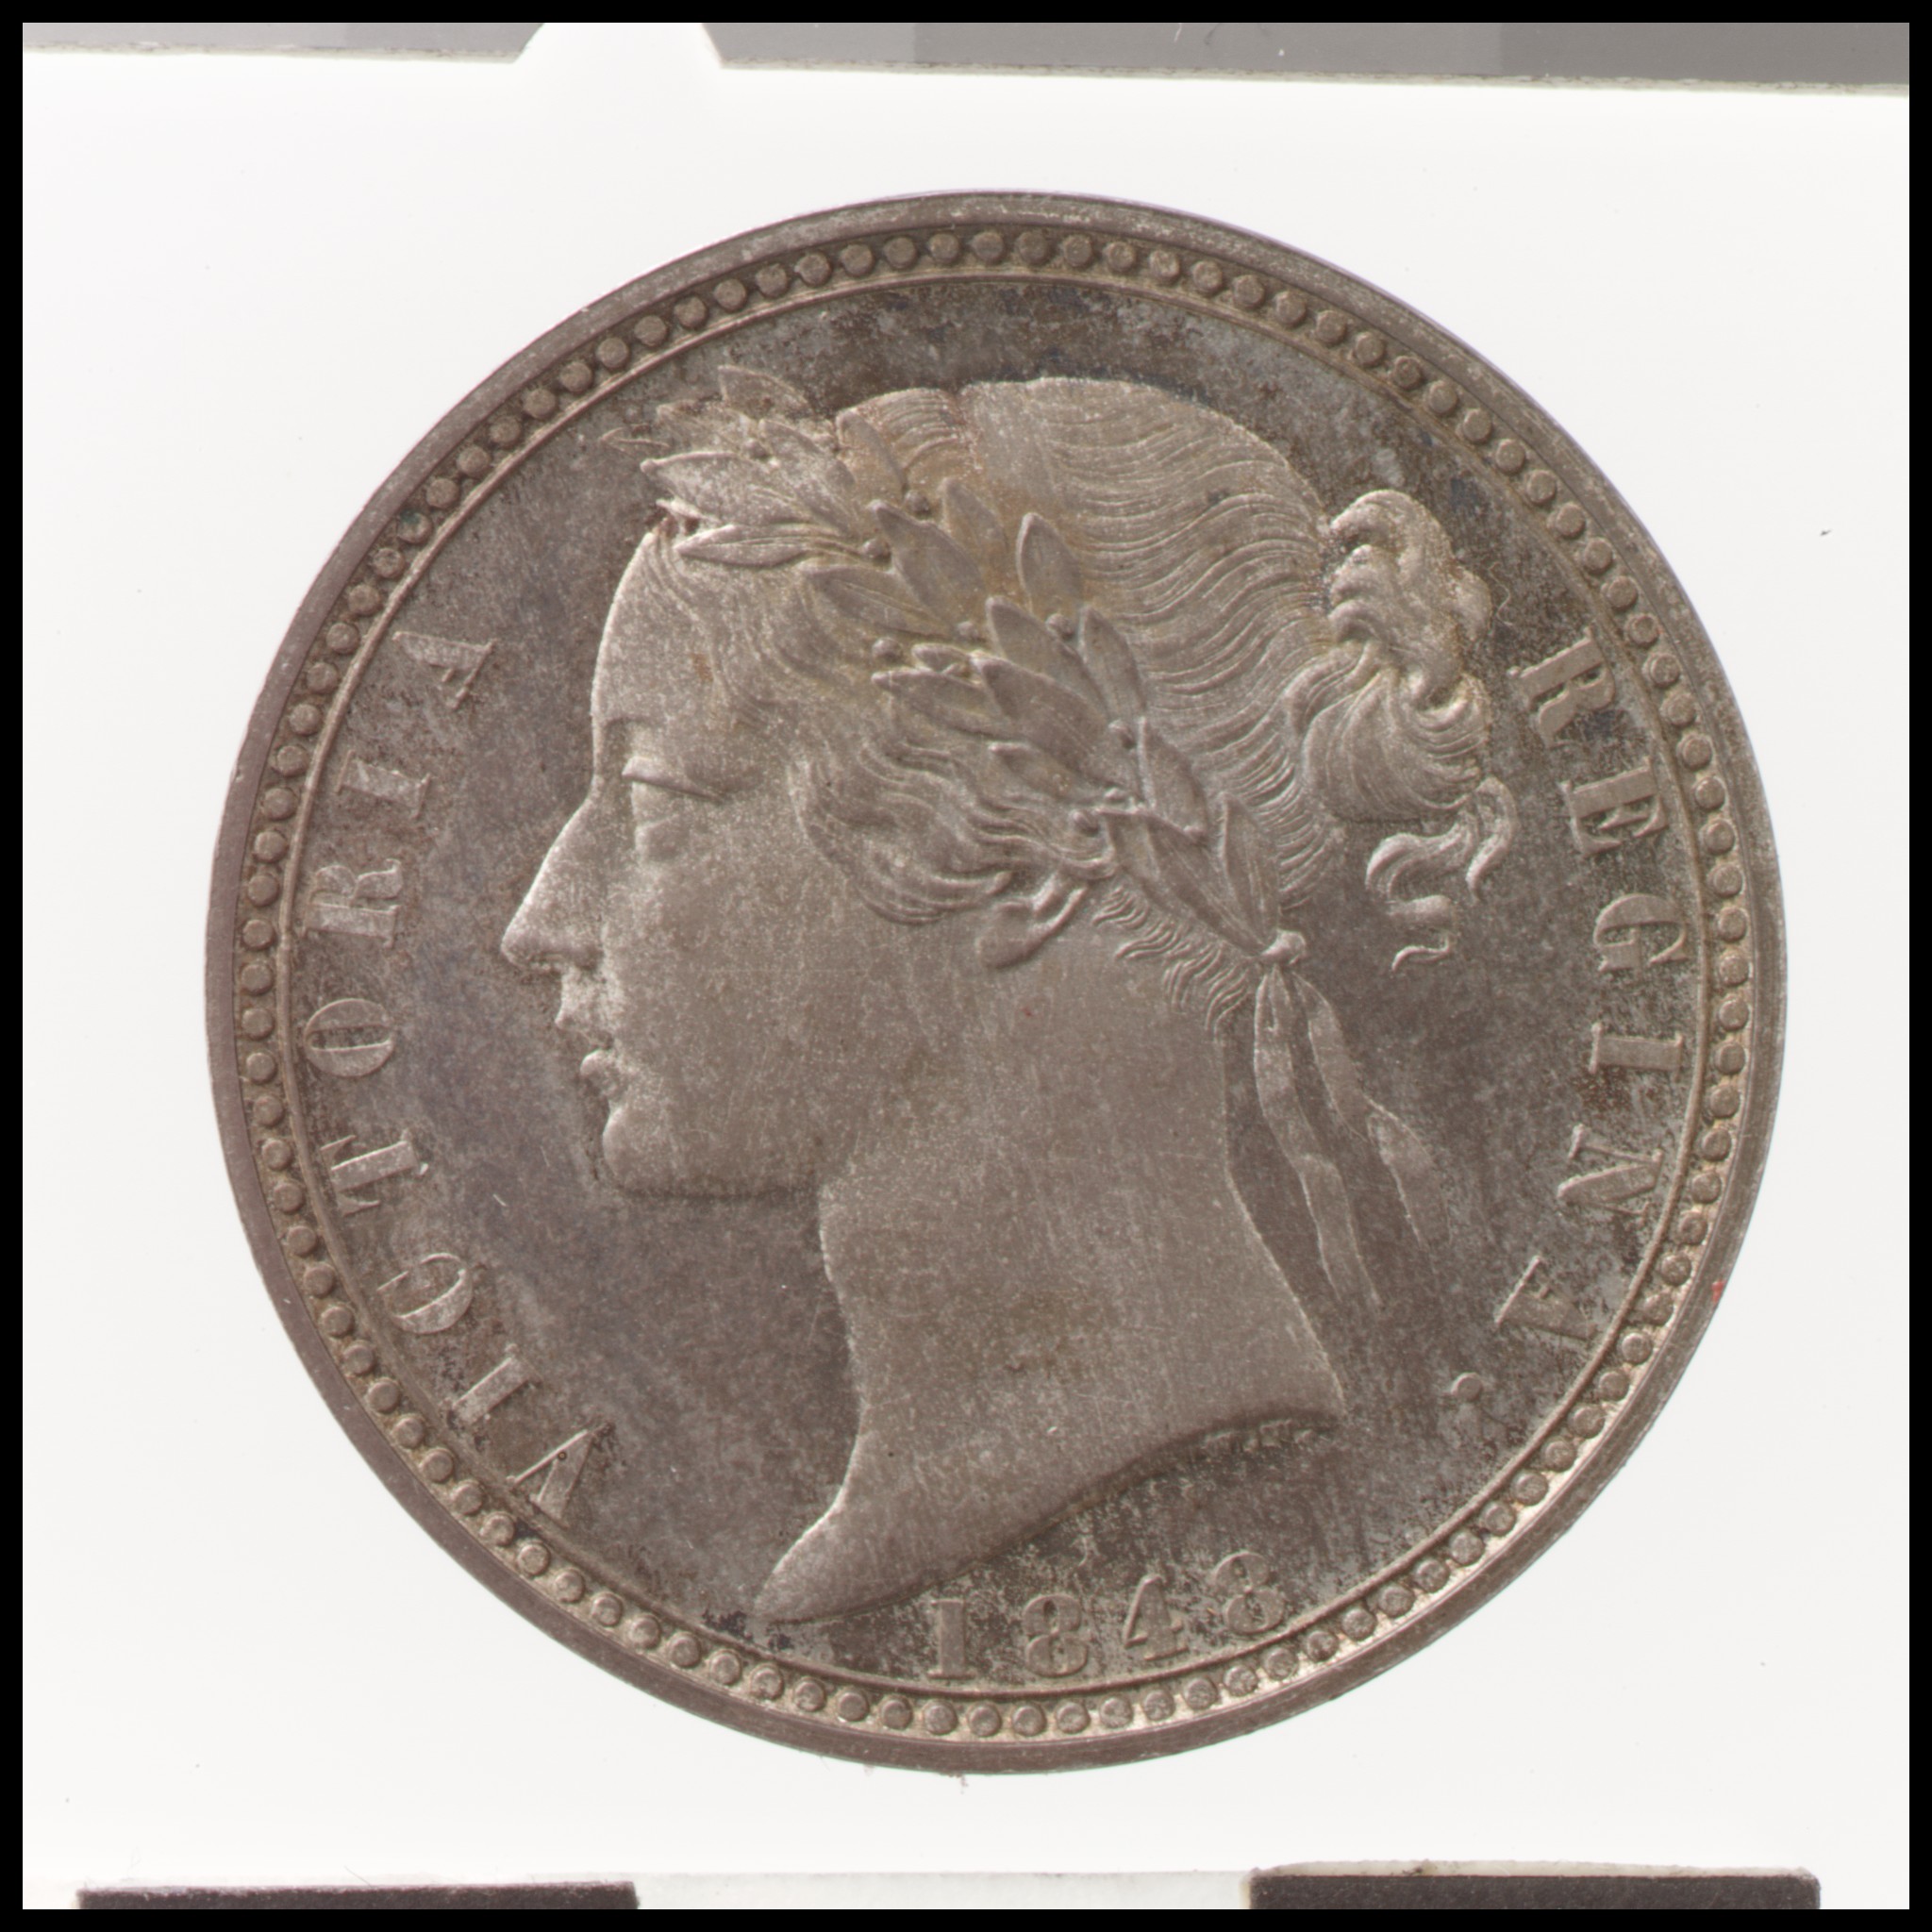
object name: proof florin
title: Queen Victoria proof florin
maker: william wyon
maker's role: artist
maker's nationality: british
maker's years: 1795-1851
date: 1848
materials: silver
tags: profiles,women,queen victoria